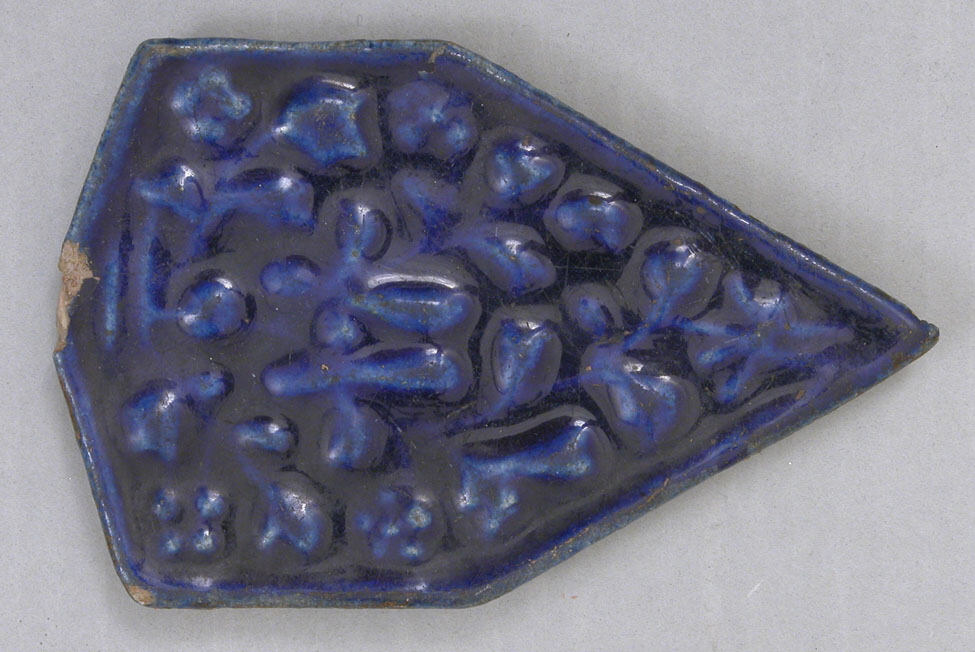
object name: tile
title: Hexagonal Tile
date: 1301-1400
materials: stonepaste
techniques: glazing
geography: iran